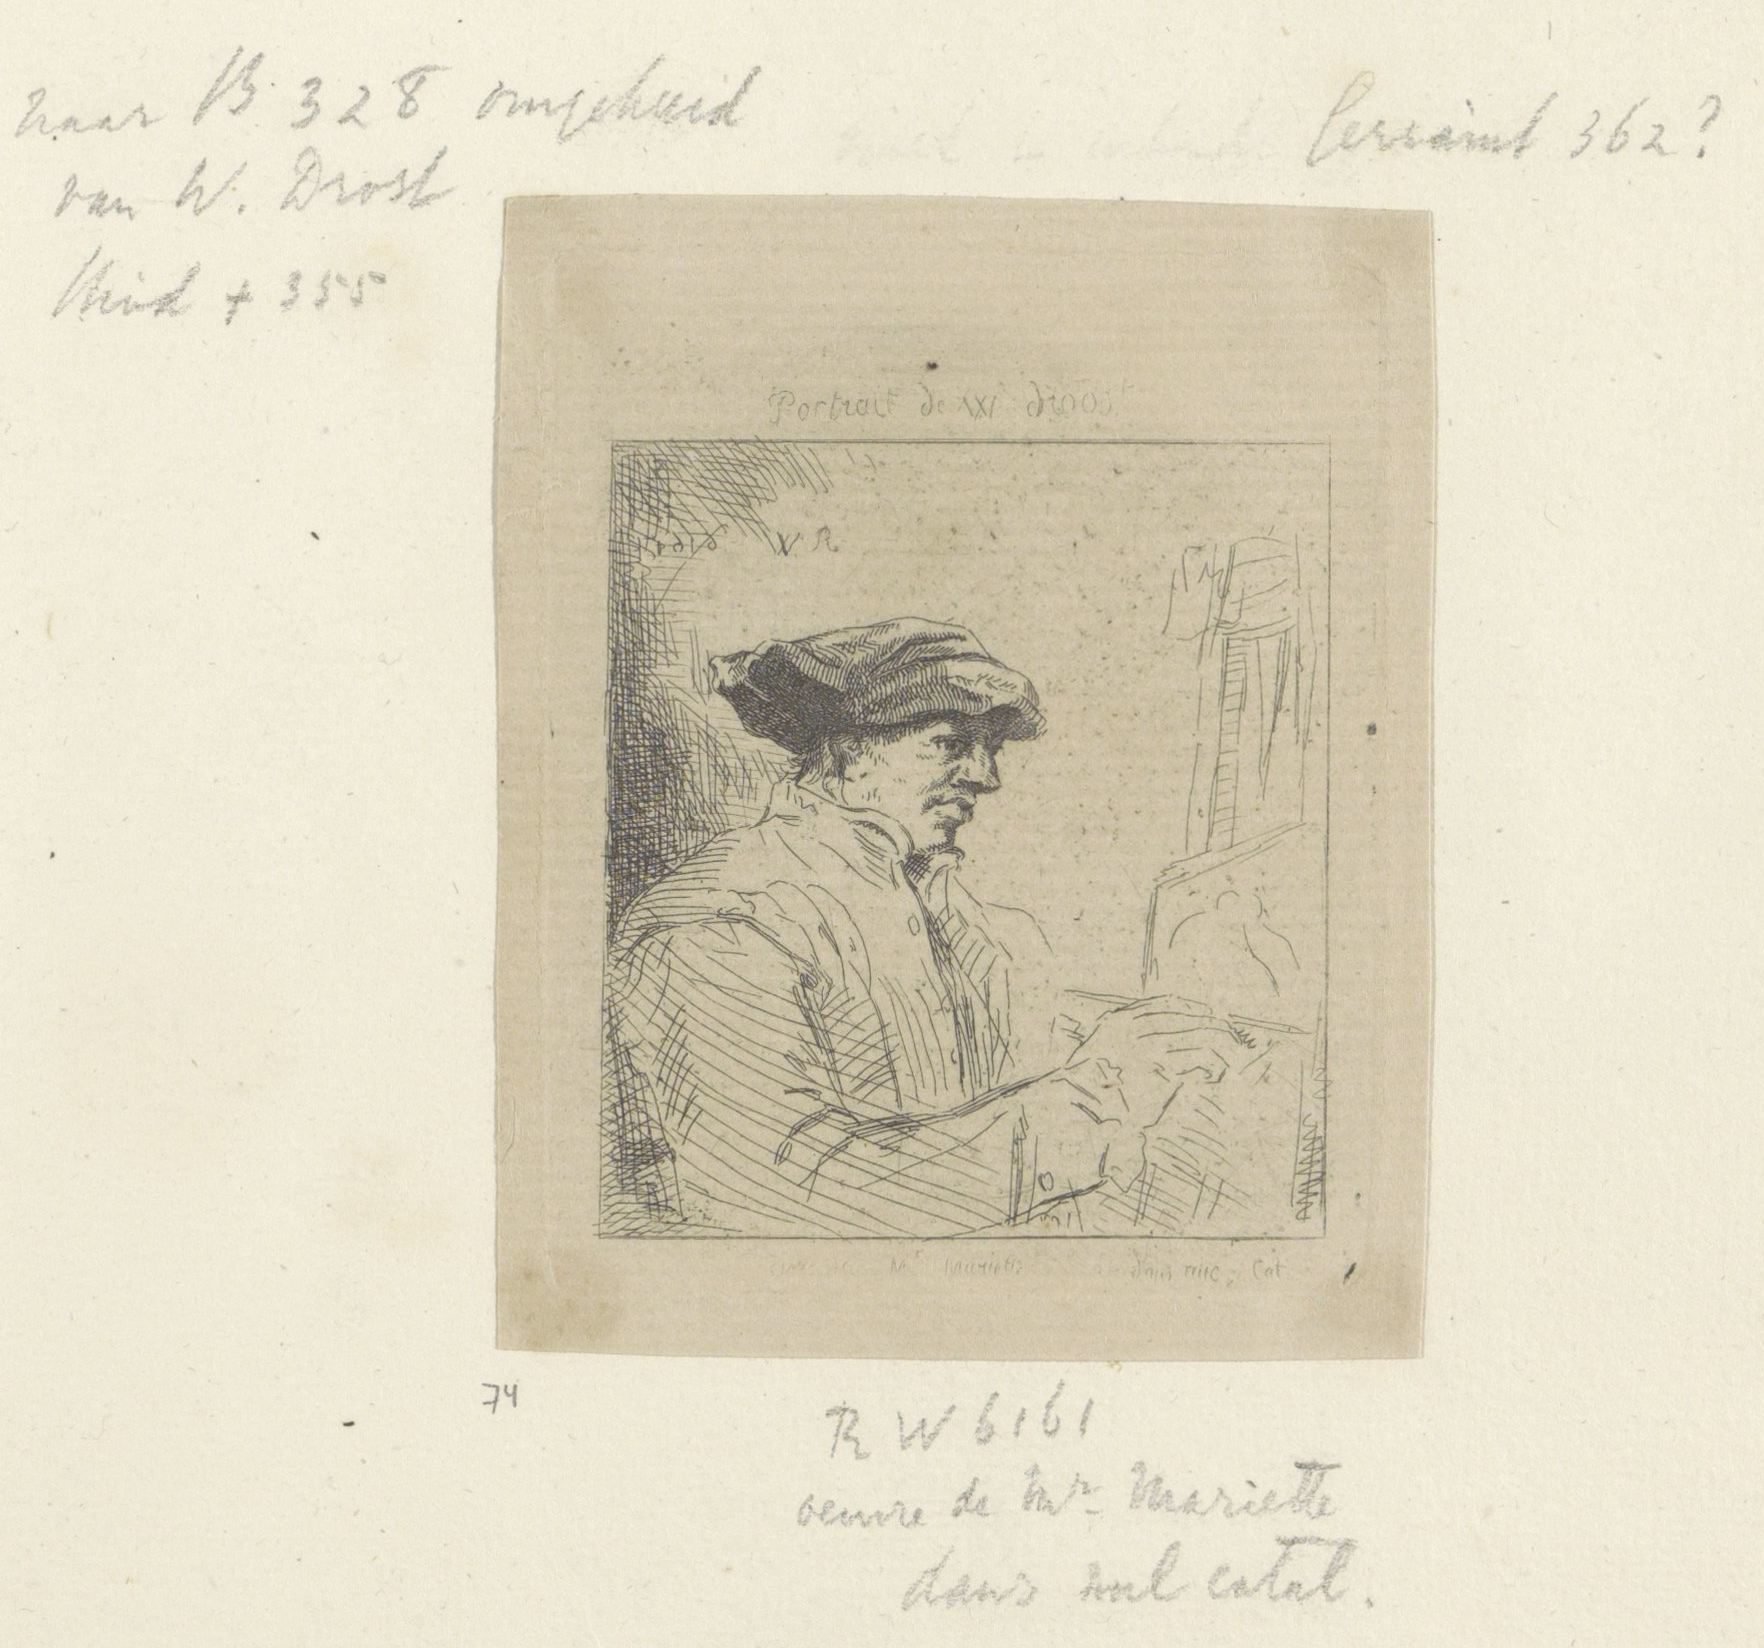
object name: kopie naar prent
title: Zelfportret van Willem Drost voor de ezel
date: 1650-1807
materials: paper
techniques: etching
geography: paris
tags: amsterdam, venice, painter, print maker, willem drost, painter at work, in his studio